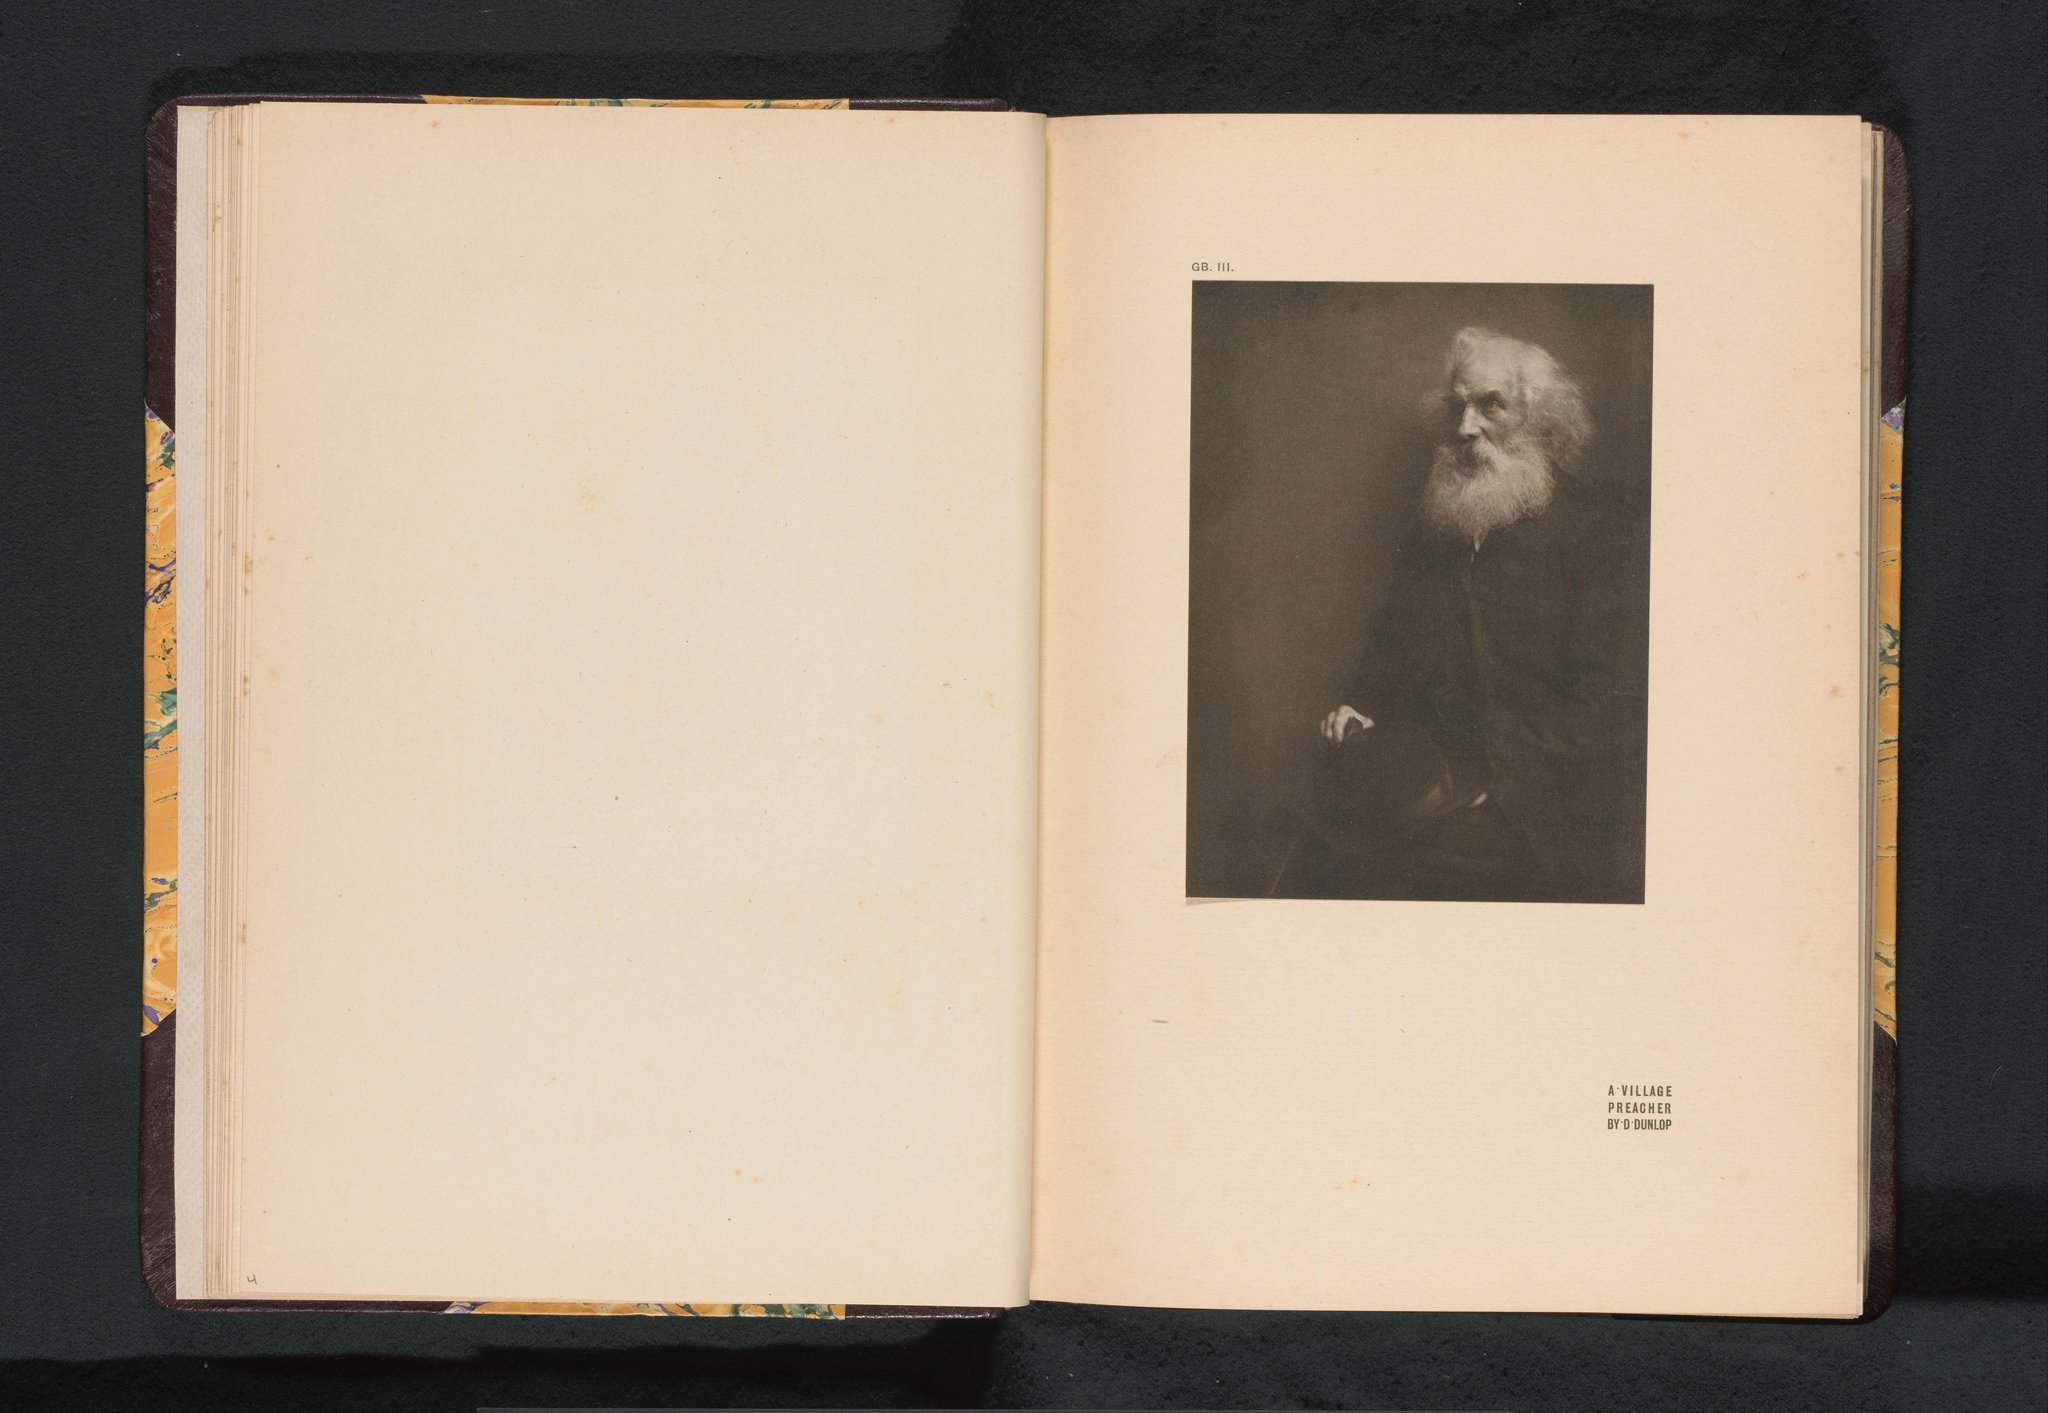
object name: photomechanical print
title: Portret van een onbekende man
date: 1900-1905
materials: paper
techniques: two-color autotype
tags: historical persons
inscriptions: inscription: ‘GB. III.’, inscription: ‘A Village preacher by D. Dunlop’